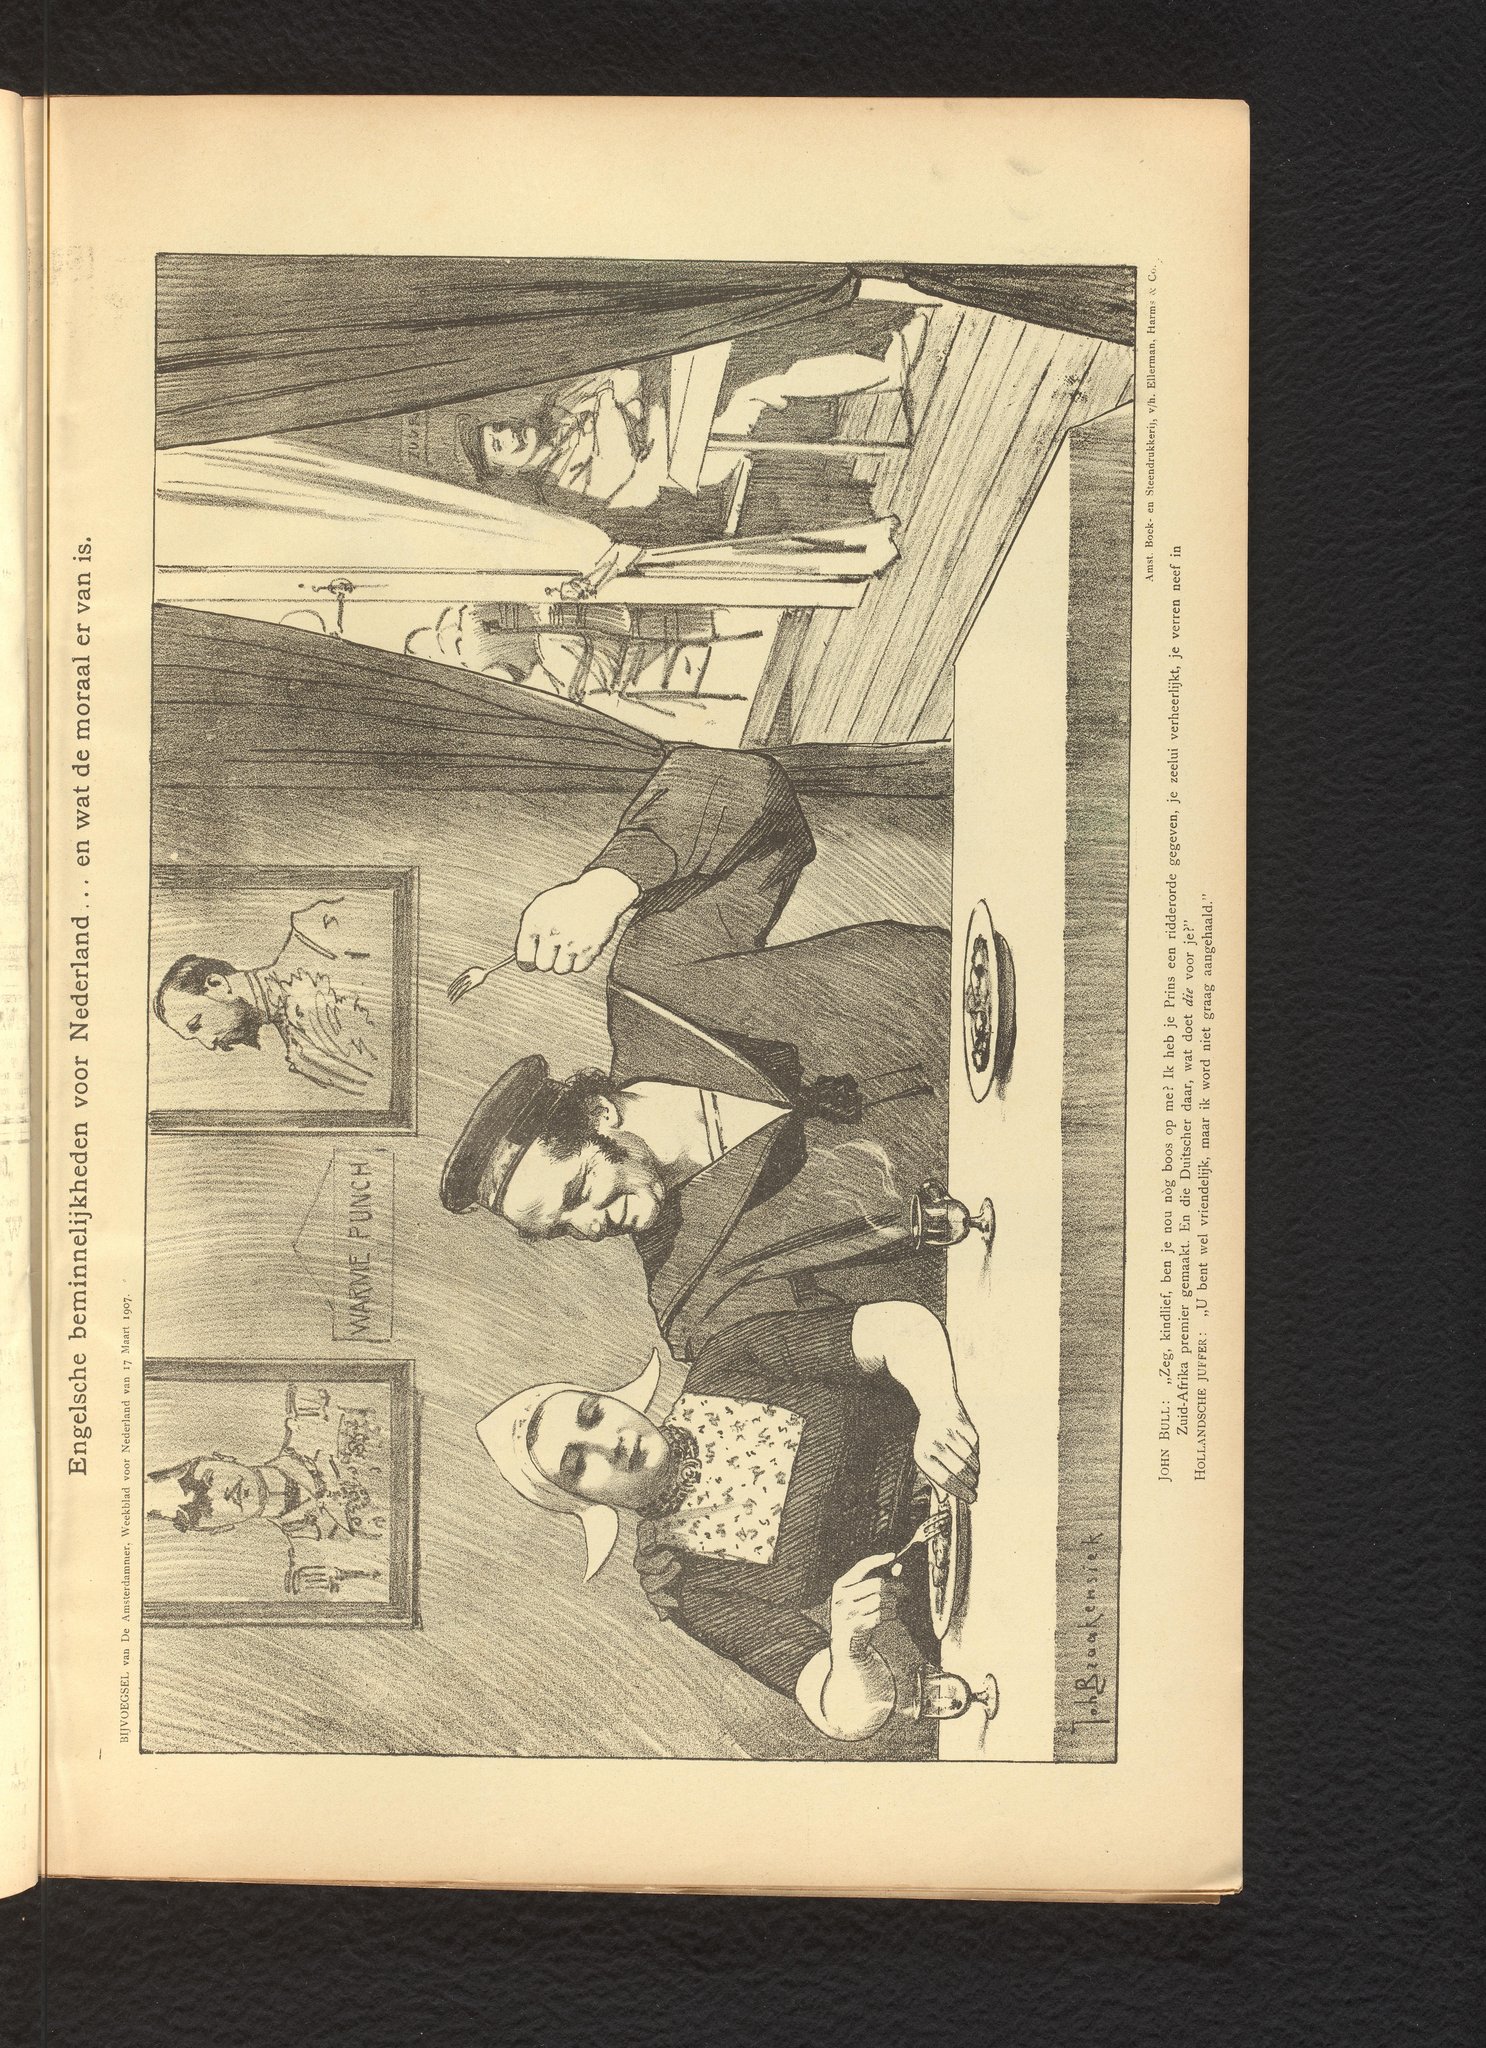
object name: cartoon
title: Engelsche beminnelijkheden voor Nederland ... en wat de moraal er van is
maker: johan braakensiek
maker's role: draughtsman, print maker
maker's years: 1858-1940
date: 1907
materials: paper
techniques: lithograph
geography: netherlands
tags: personifications of countries, nations, states, districts, etc., folk costume, regional costume, courting, restaurant, political caricatures and satires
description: In een restaurant maakt John Bull (Engeland) de Hollandse Juffer (Nederlandse Maagd), in Volendamse klederdracht, het hof en legt zijn hand op haar schouder. Op de achtergrond kijkt de Duitse keizer Wilhelm II chagrijnig toe.